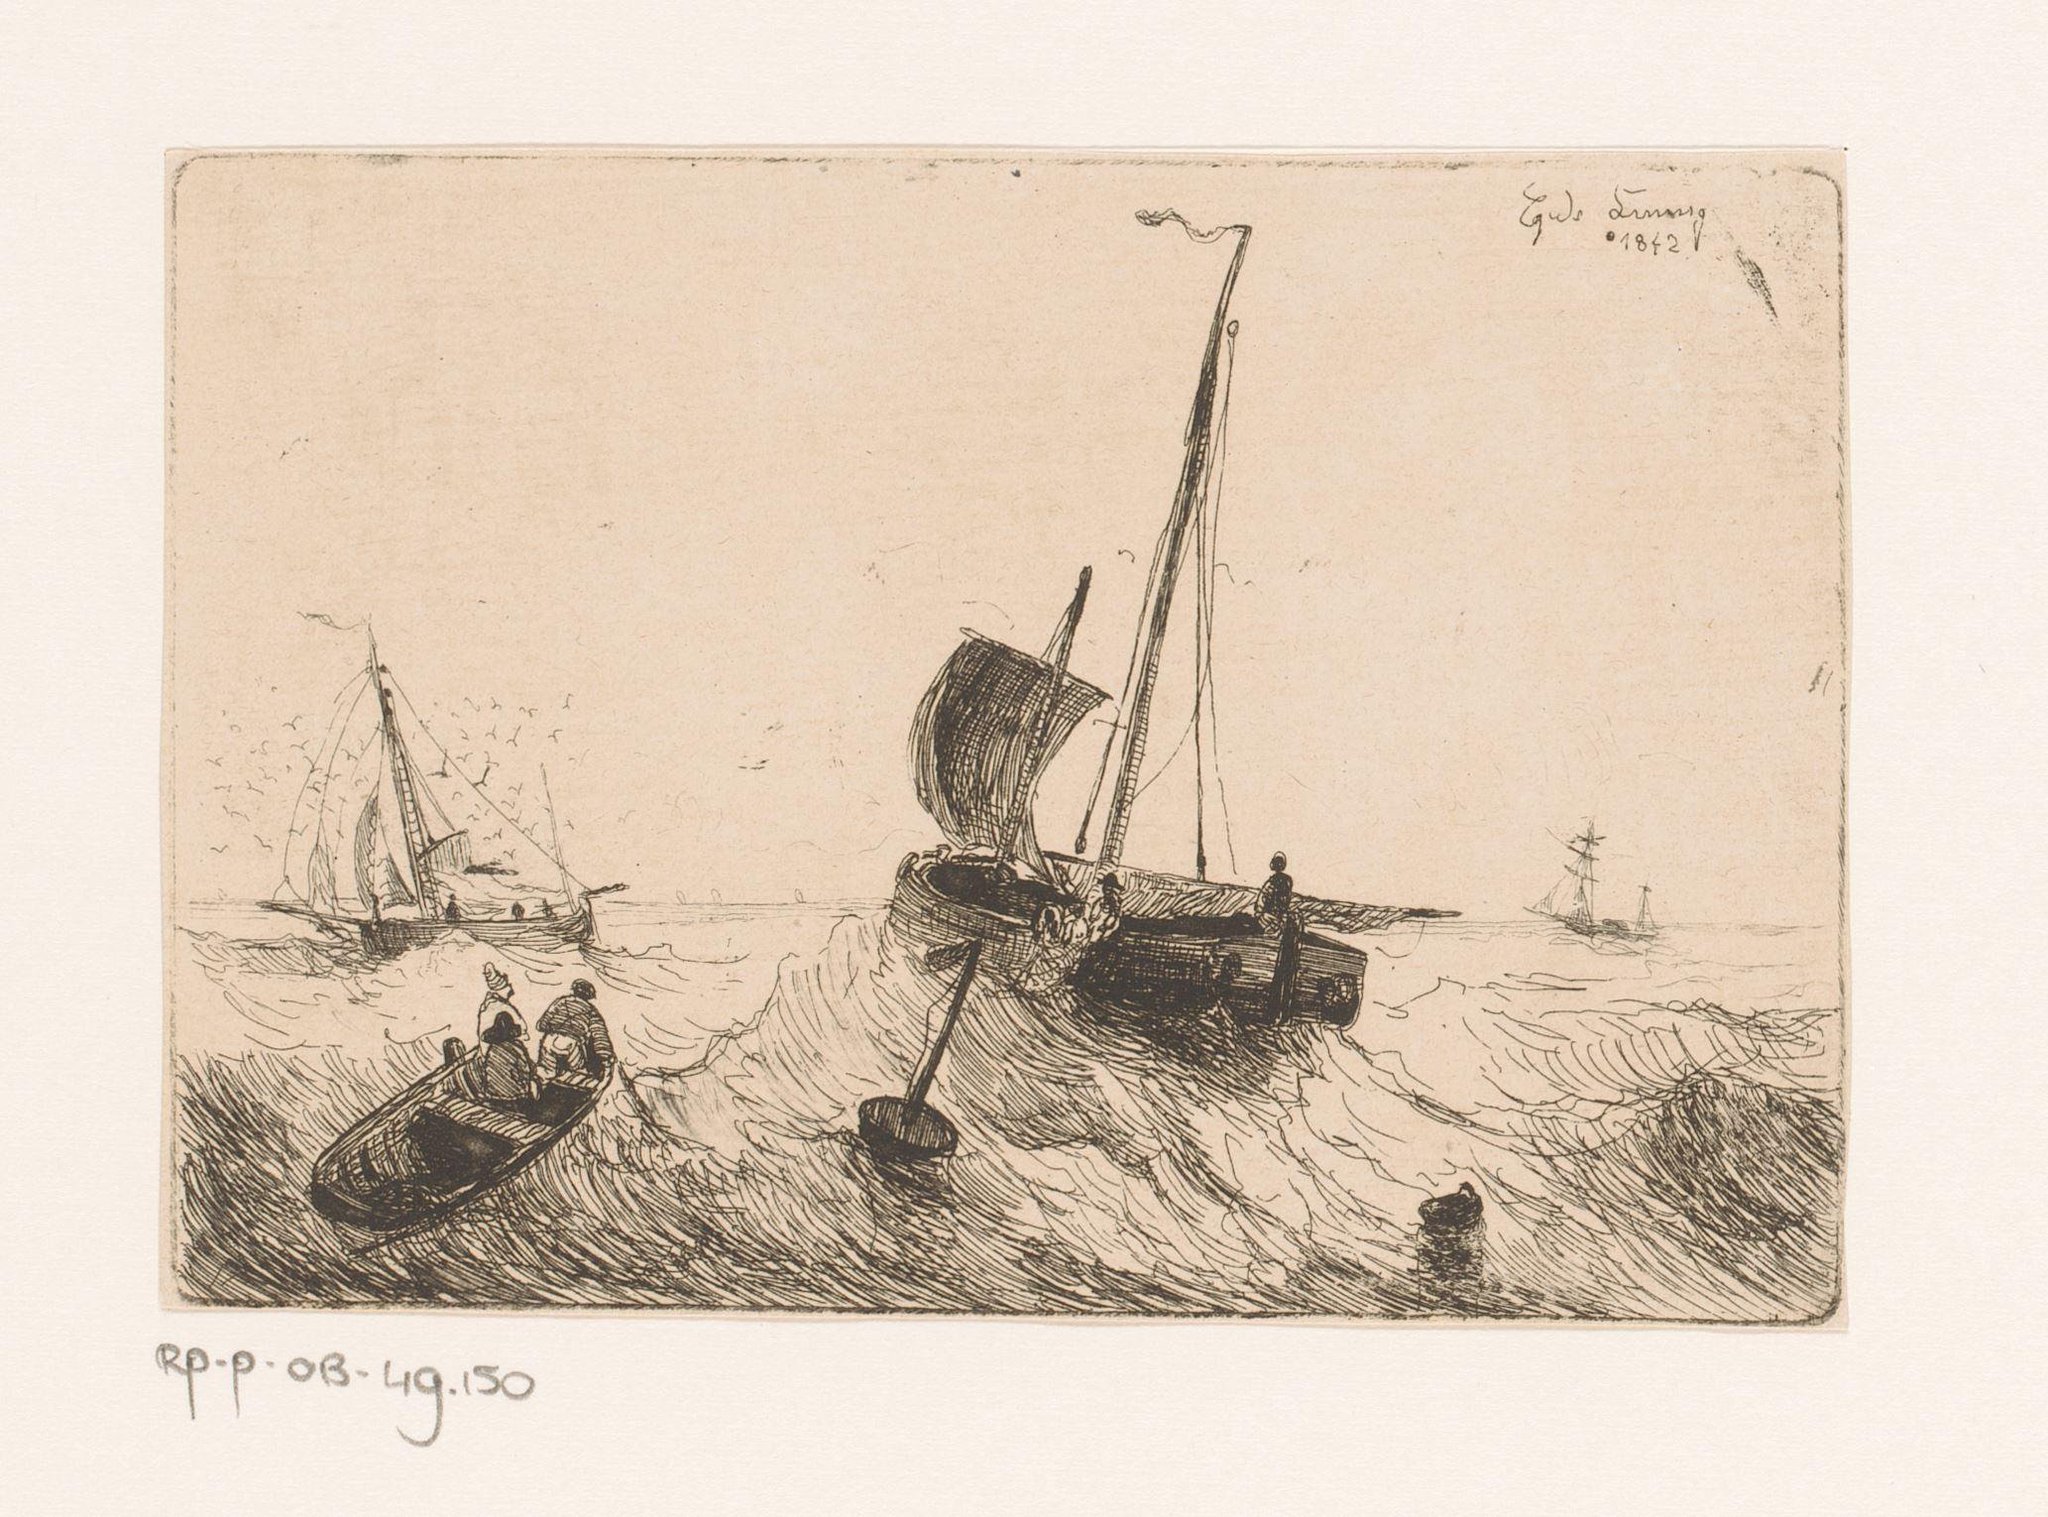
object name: print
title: Portret van een onbekende man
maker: louis le nain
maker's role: print maker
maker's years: 1851-1939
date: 1861-1939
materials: paper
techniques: etching, intaglio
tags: historical persons, old man